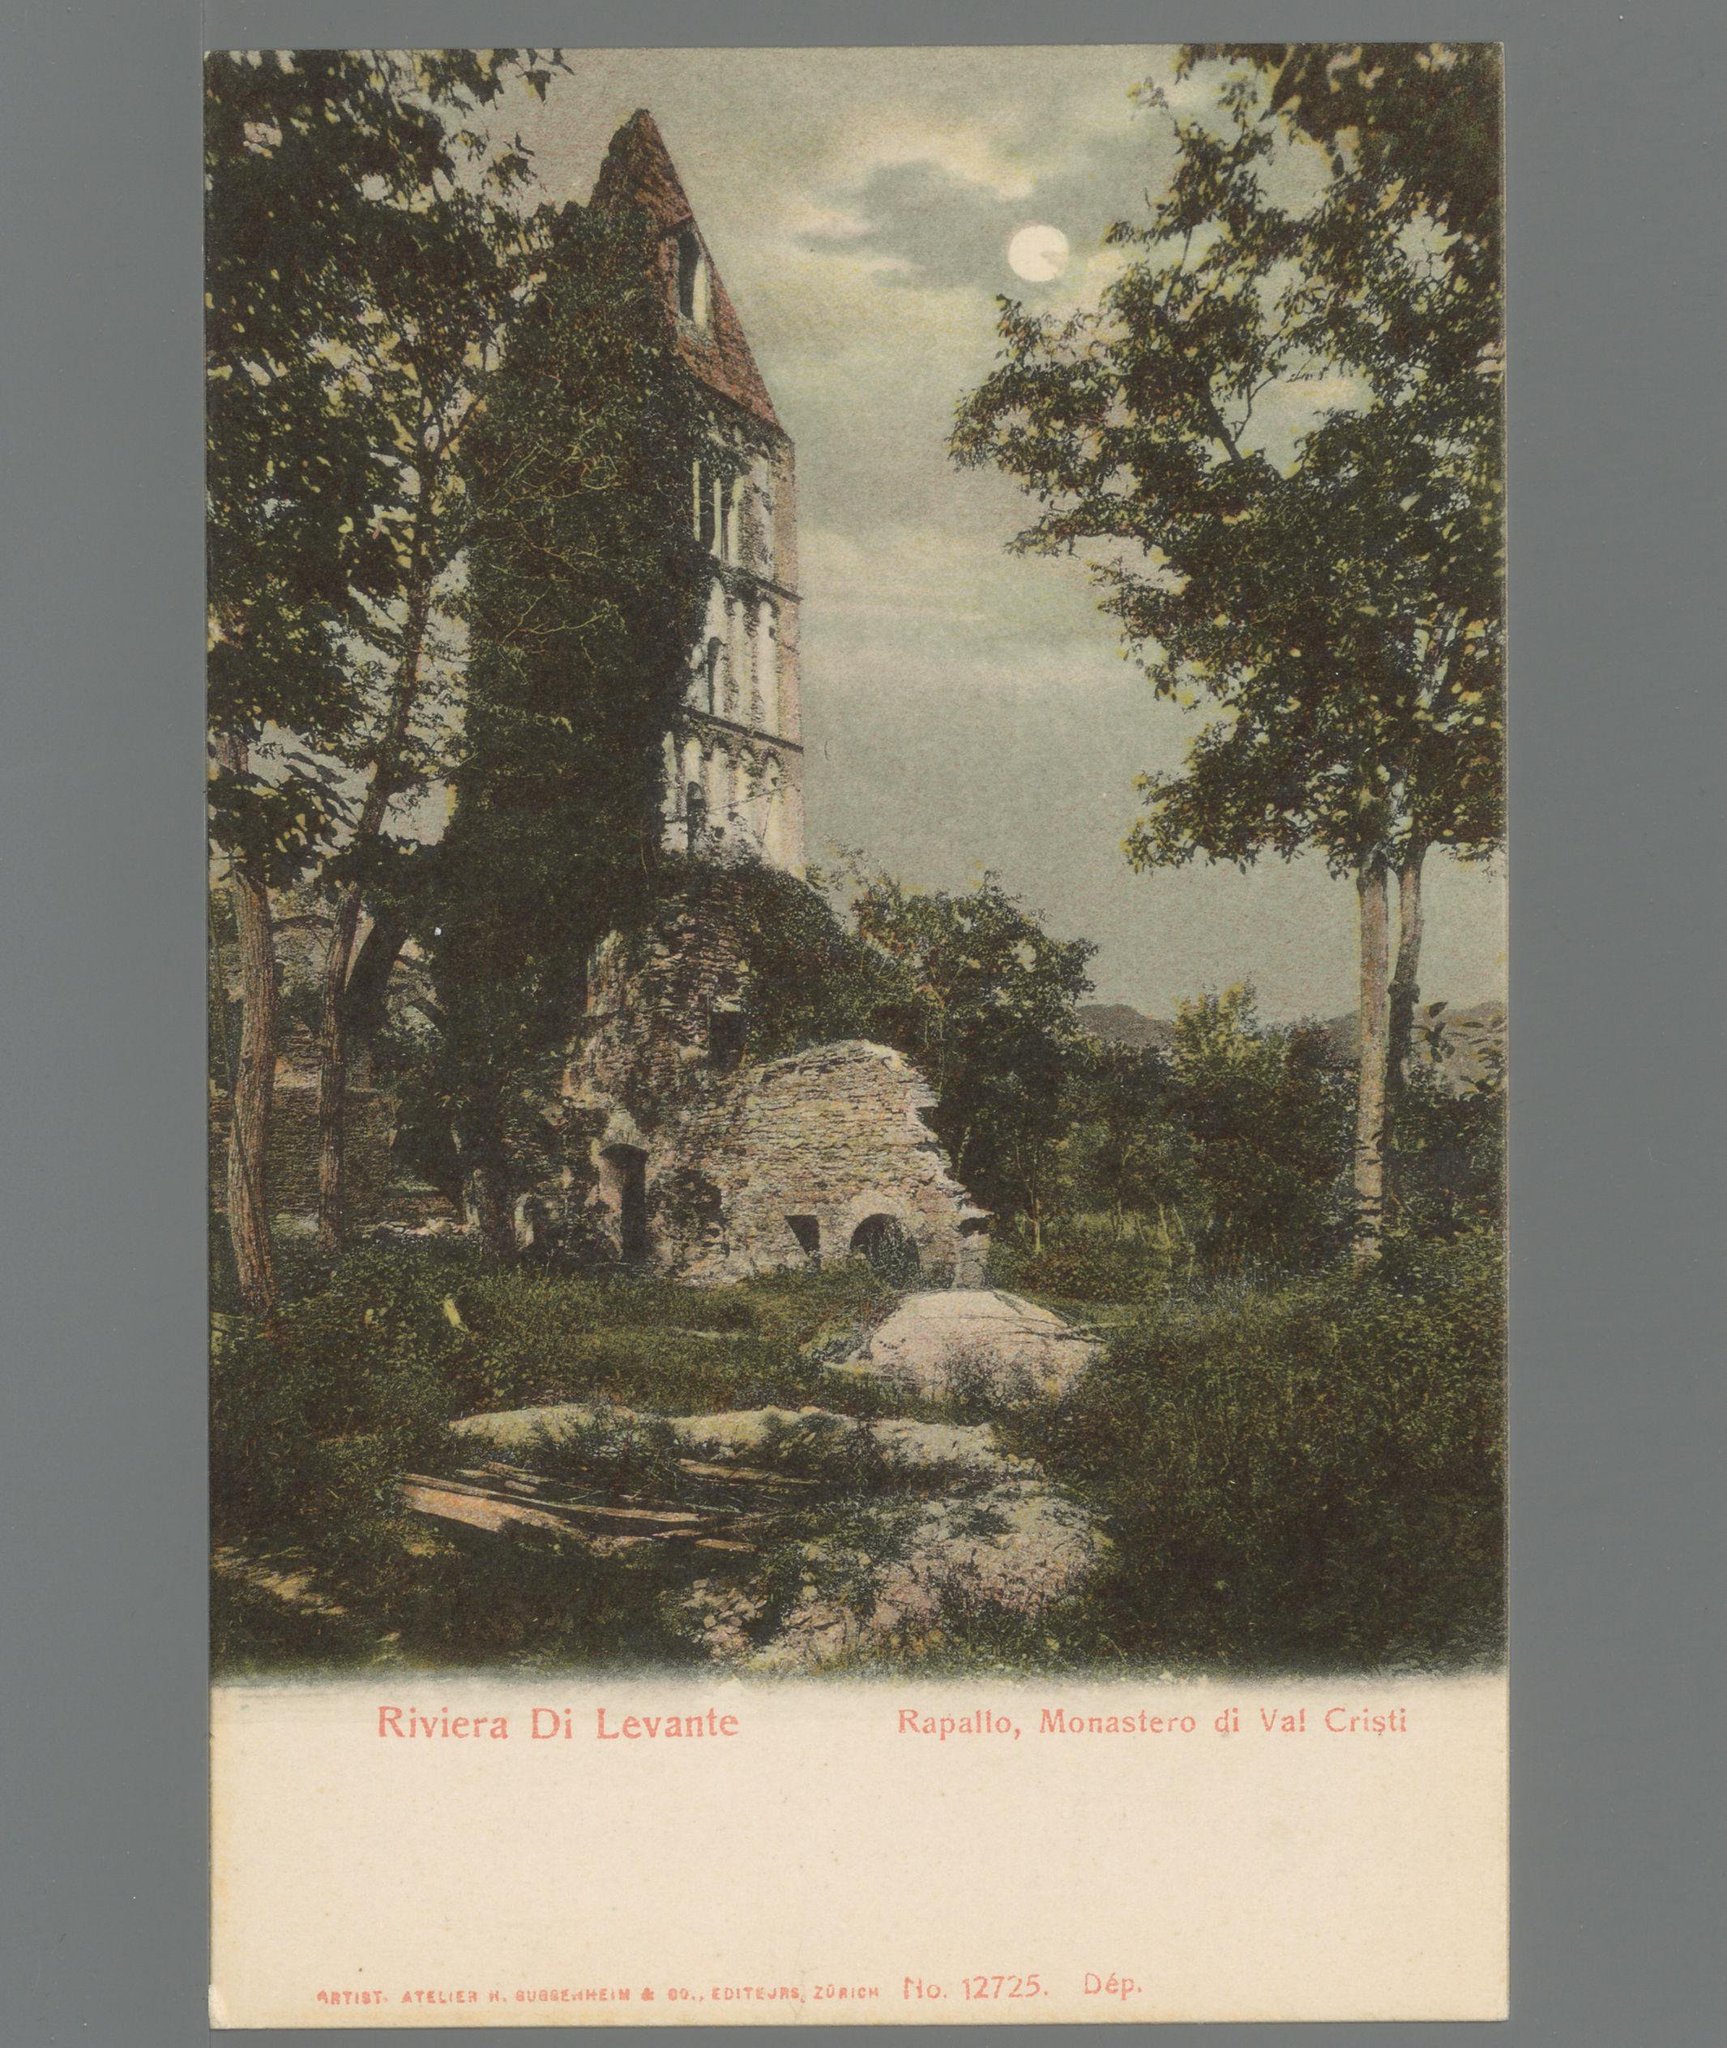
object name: photomechanical print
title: Riviera di Levante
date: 1893-1905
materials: cardboard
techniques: photograph, lithograph, writing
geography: zurich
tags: landscapes in the temperate zone, ruin of church, monastery, etc.